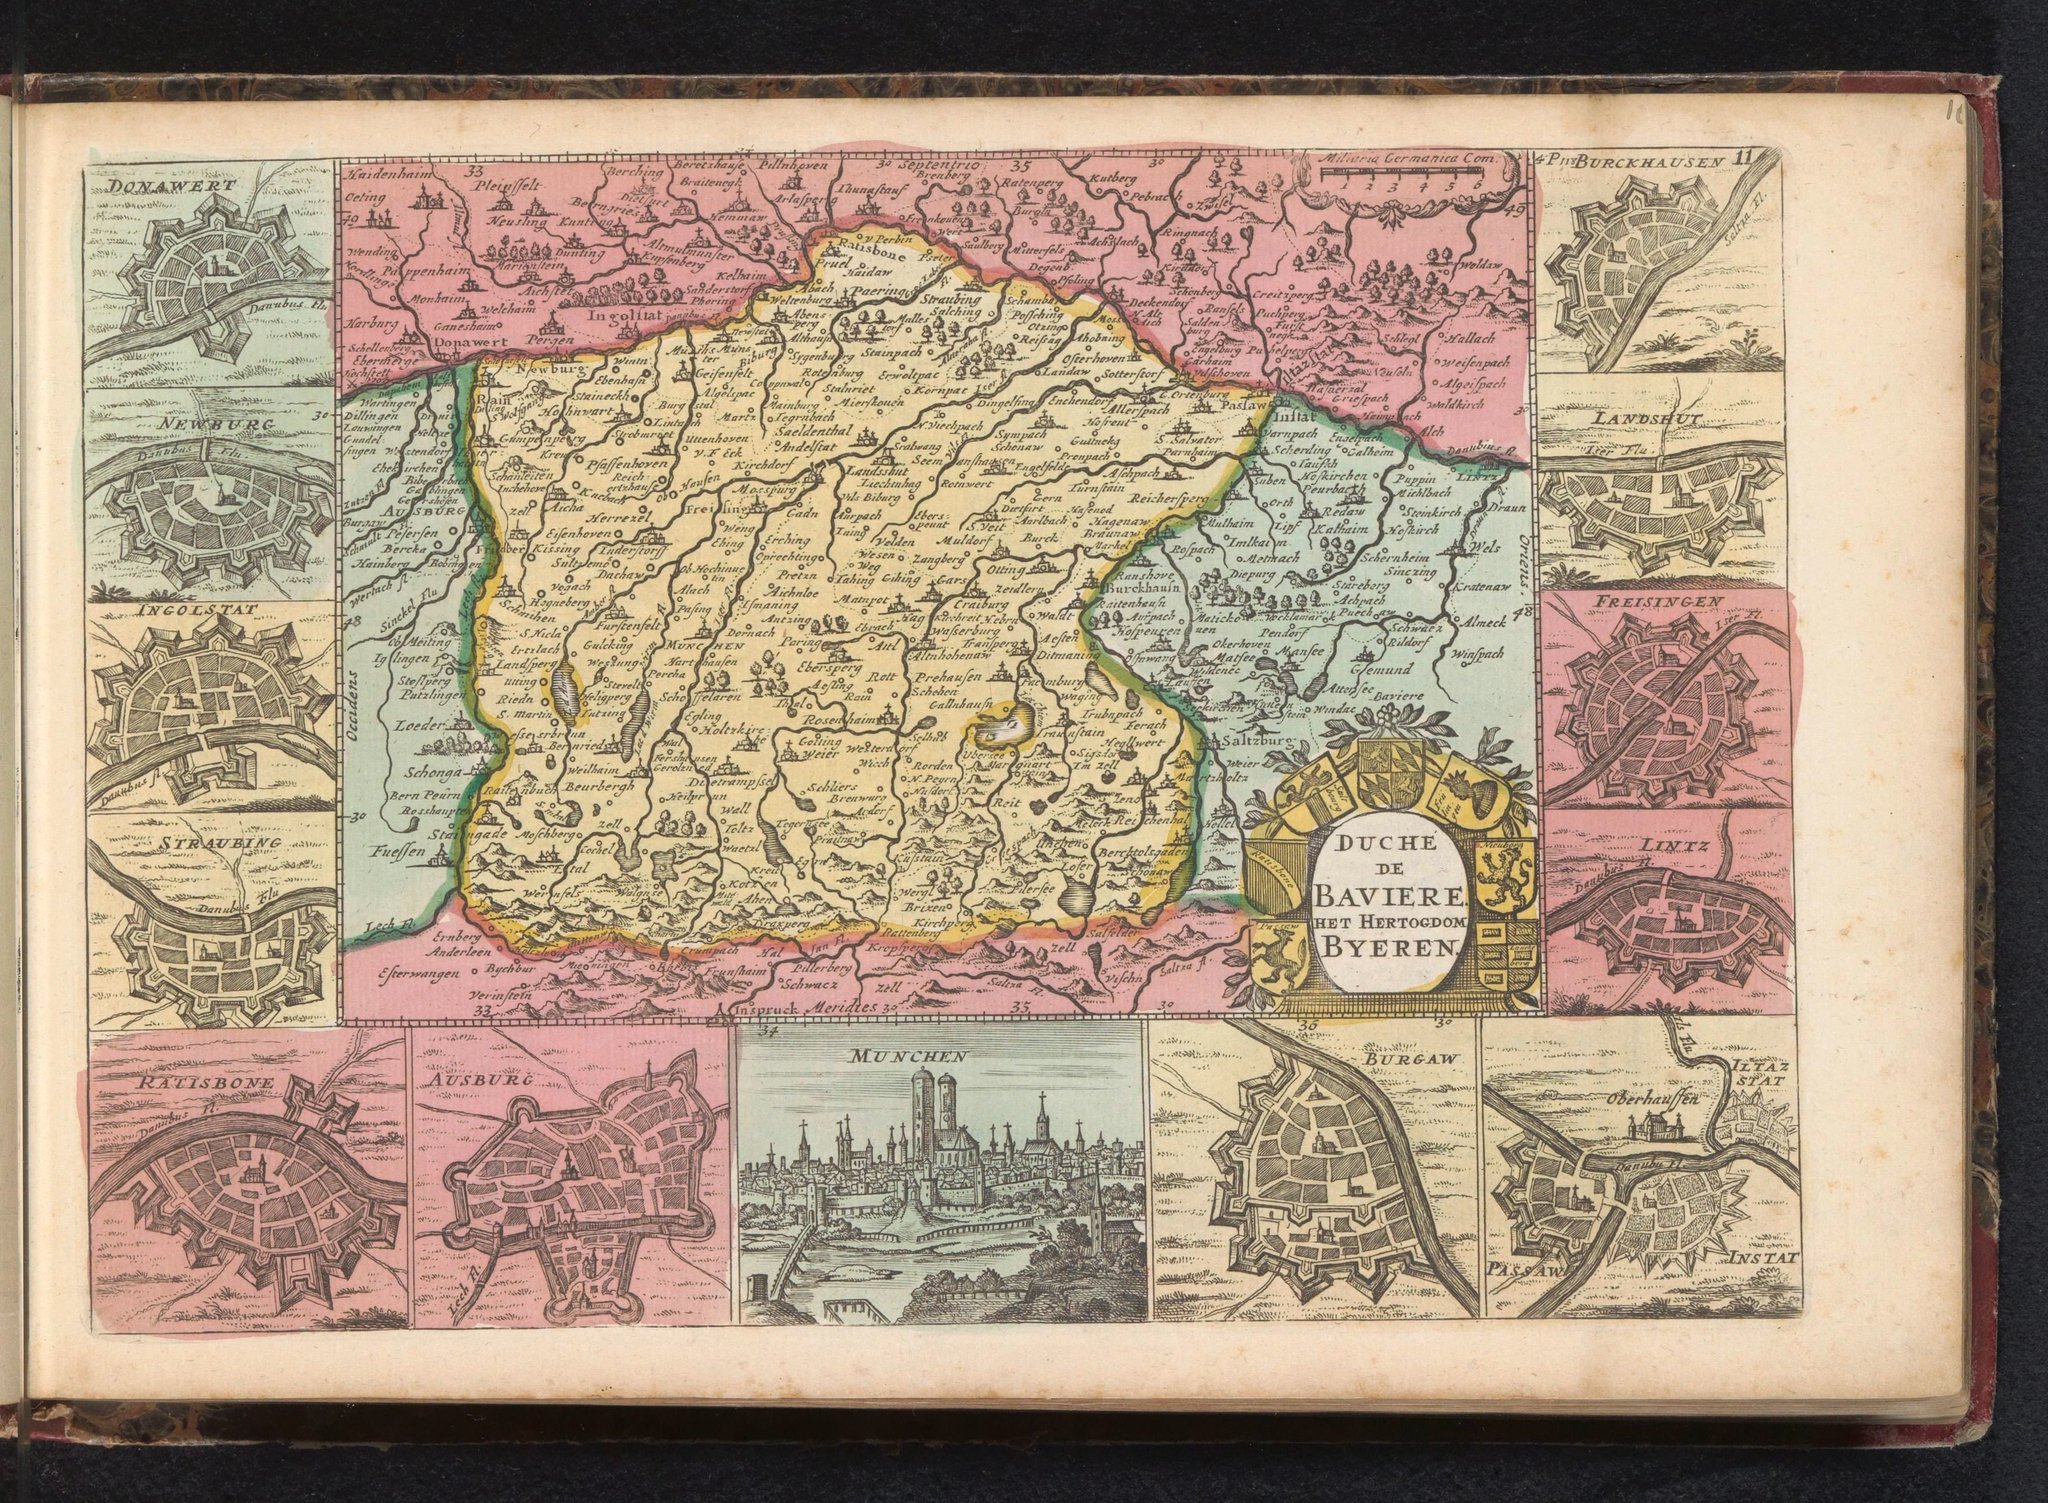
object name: print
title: Duché de Baviere. Het Hertogdom Byeren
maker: Anonymous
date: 1700-1705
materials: paper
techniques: engraving, hand coloring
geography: amsterdam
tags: maps of separate countries or regions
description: Kaart van het hertogdom Beieren. De kaart omringd met dertien plattegronden van steden. Onderdeel van een atlas met 223 kaarten van landen en steden en oorlogstaferelen in Europa in de periode ca. 1690-1735.